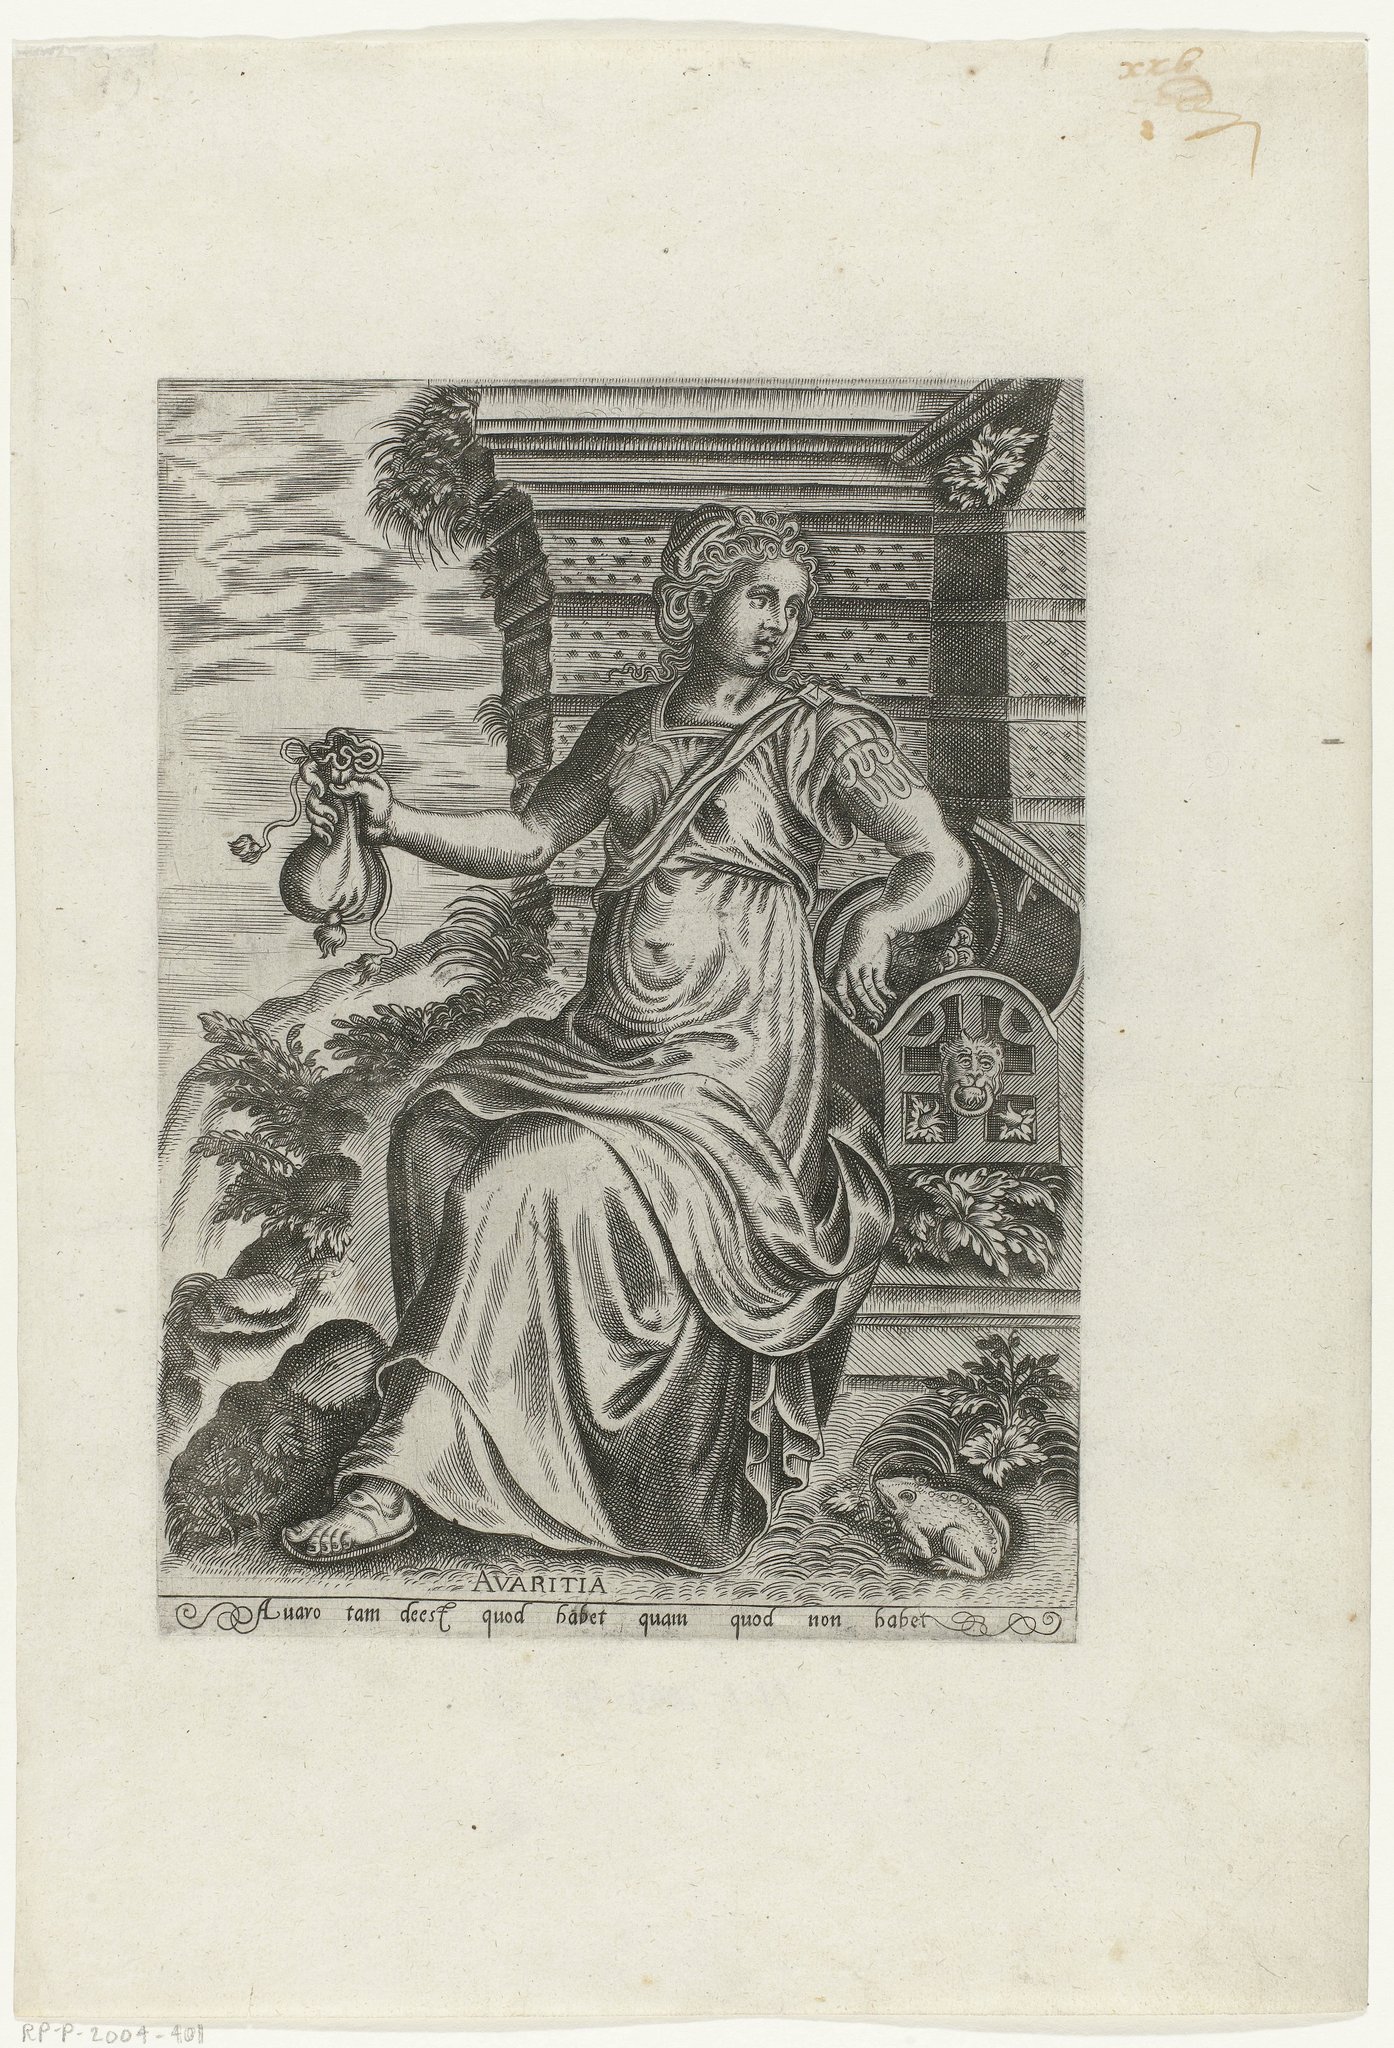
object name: print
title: Gierigheid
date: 1575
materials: paper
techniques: engraving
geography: antwerp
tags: tailless amphibians: frog, purse, money-bag, covetousness; 'avaritia' (ripa) ~ personification of one of the seven deadly sins, money-chest, treasure-chest, money-box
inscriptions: collector's mark: Lugt 2228, collector's mark: Lugt 2760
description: Personificatie van Gierigheid in de gedaante van een vrouw in antieke toga, zittend in landschap bij muur. In haar rechterhand houdt ze een geldbuidel en met de linkerhand tast ze in een geldkist die naast haar staat. Rechtsvoor een kikker. In de marge een éénregelig onderschrift in het Latijn.